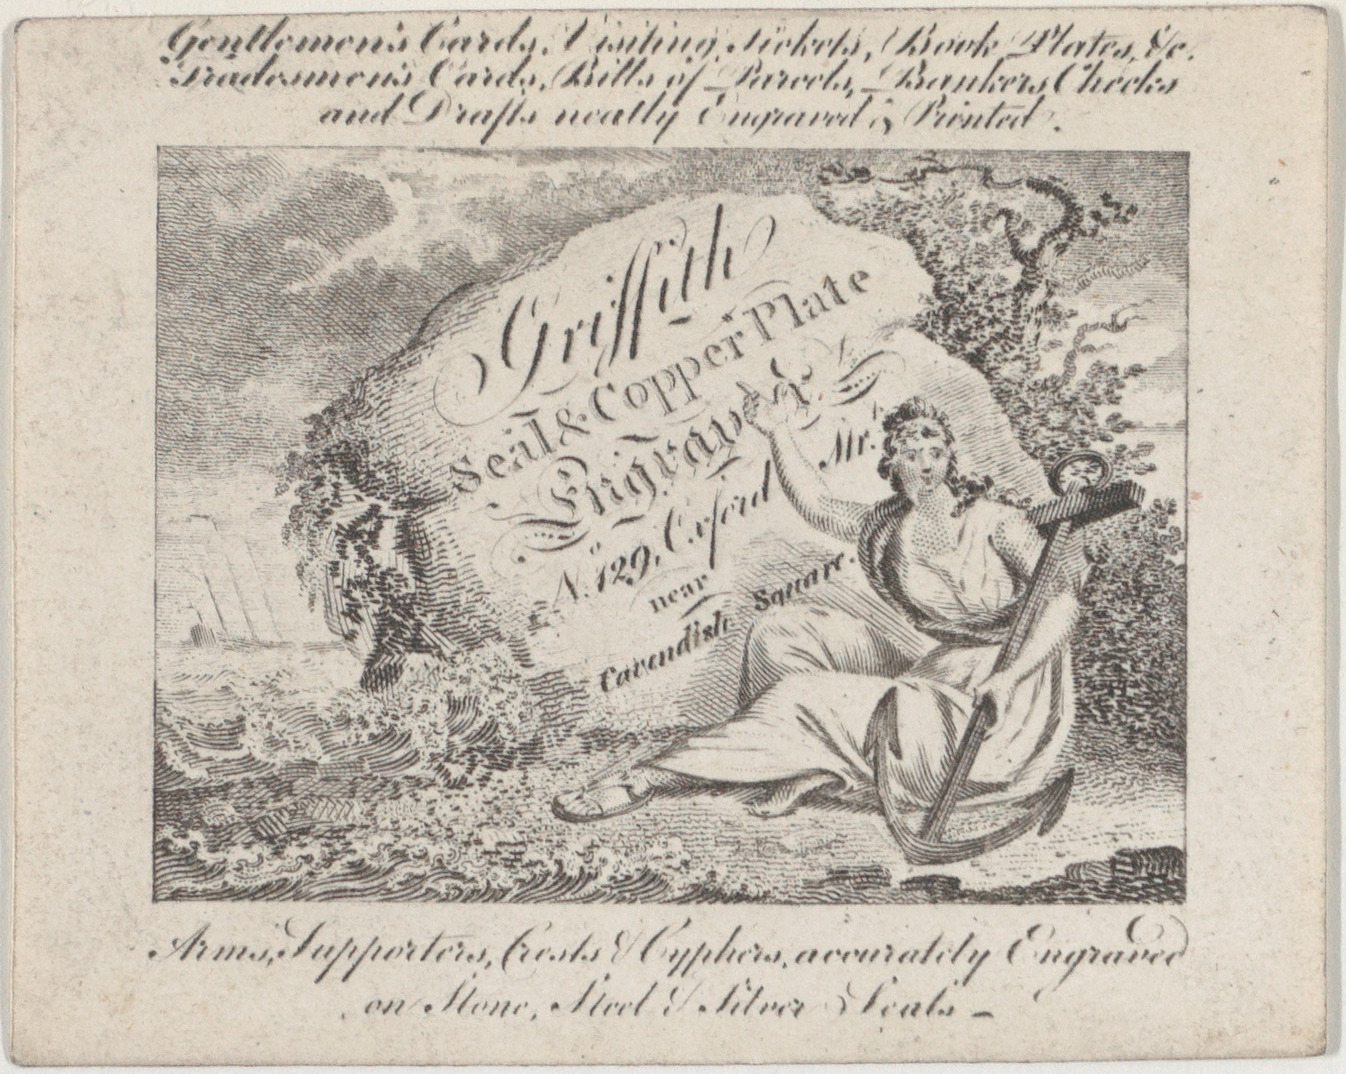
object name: print, trade card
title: Trade Card for Robert Griffith, Seal and Copper Plate Engraver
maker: anonymous, british, 18th century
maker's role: artist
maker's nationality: british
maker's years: 1700-1800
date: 1701-1800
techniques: engraving